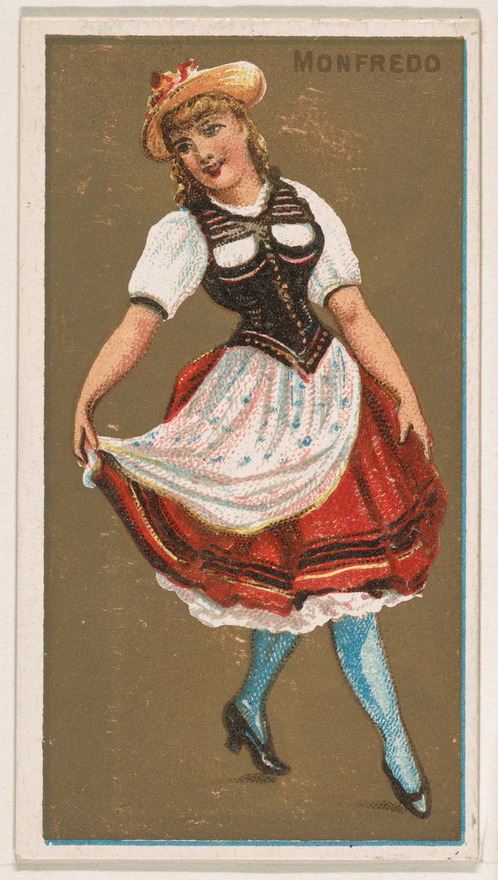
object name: print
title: Monfredo, from National Dances (N225, Type 1) issued by Kinney Bros.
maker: kinney brothers tobacco company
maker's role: publisher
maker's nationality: american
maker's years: 1869-2011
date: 1889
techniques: color lithograph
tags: dance,women